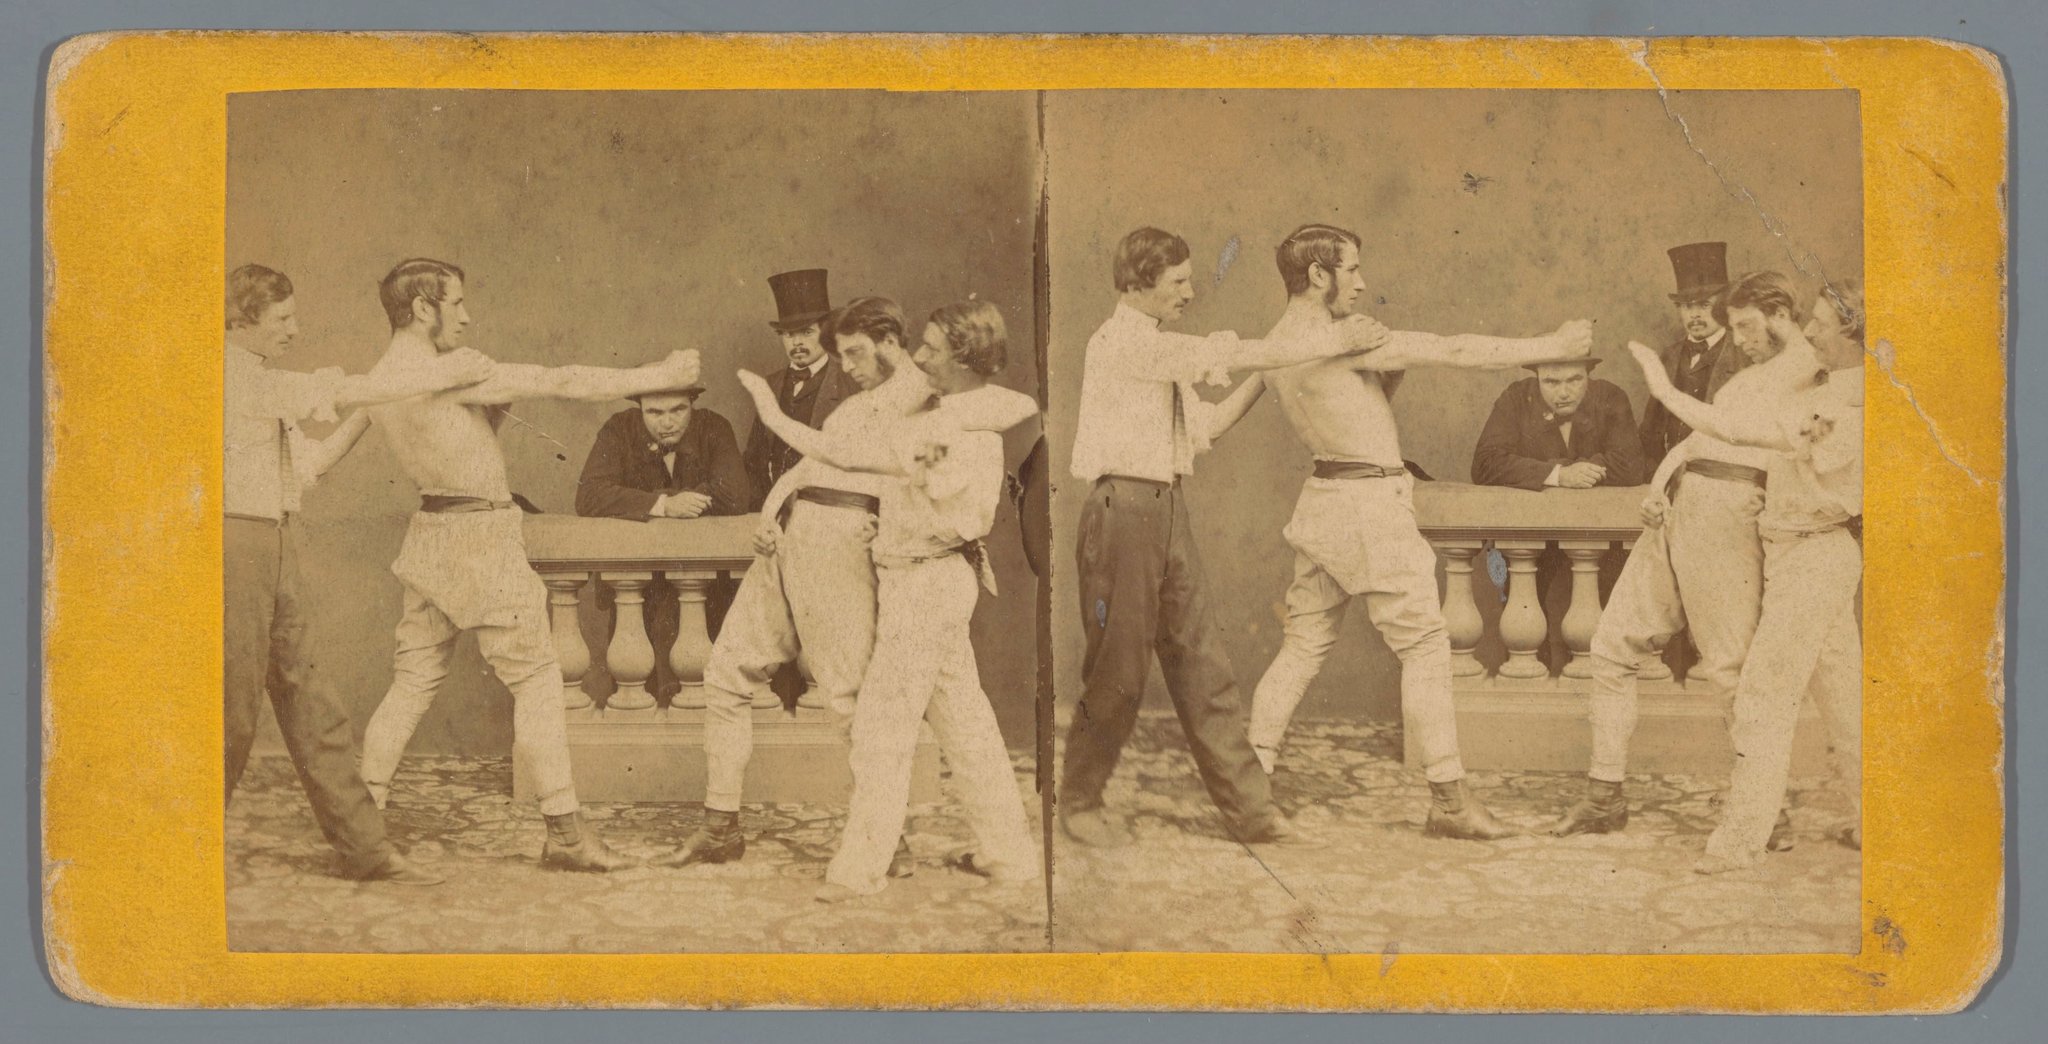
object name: stereograph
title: Theatrale voorstelling van twee vechtende mannen met secondanten en toeschouwers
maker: Anonymous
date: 1850-1880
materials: cardboard, photographic support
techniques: albumen print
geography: europe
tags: set, scenery ~ stage, fist-fight, europe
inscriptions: inscription: ‘F. 2,50’